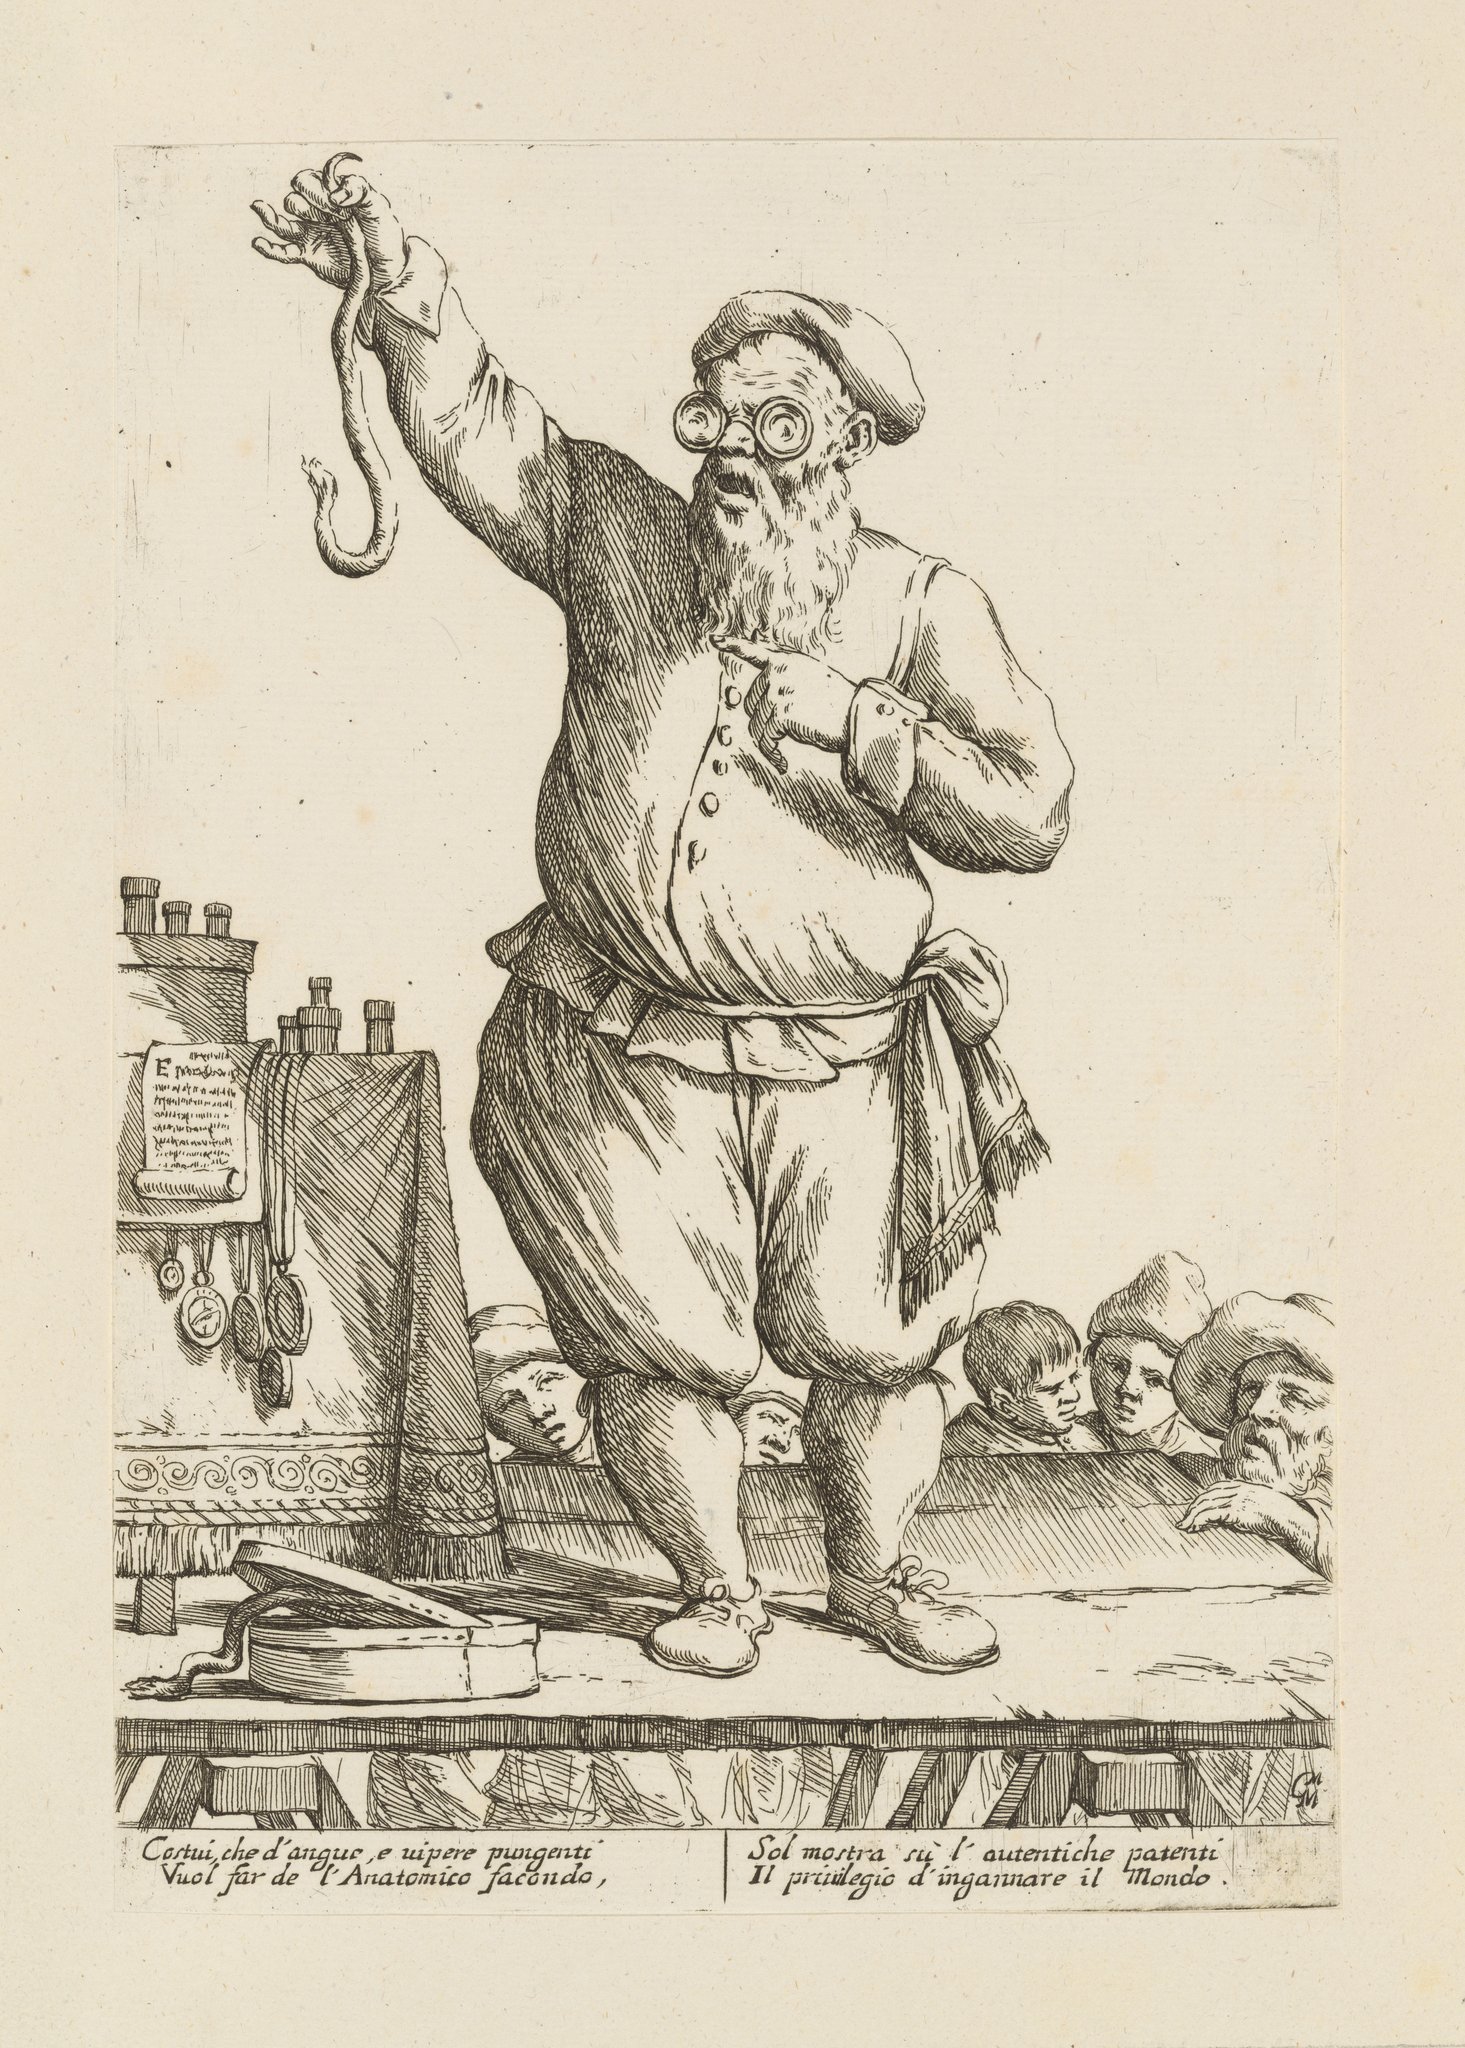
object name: print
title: Charlatan on His Stage, Holding a Snake, from Di Bologna l'Arti per via D'An.ibal' Ca.rac, plate 25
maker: giuseppe maria mitelli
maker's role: artist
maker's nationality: italian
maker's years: 1634-1718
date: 1660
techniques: etching